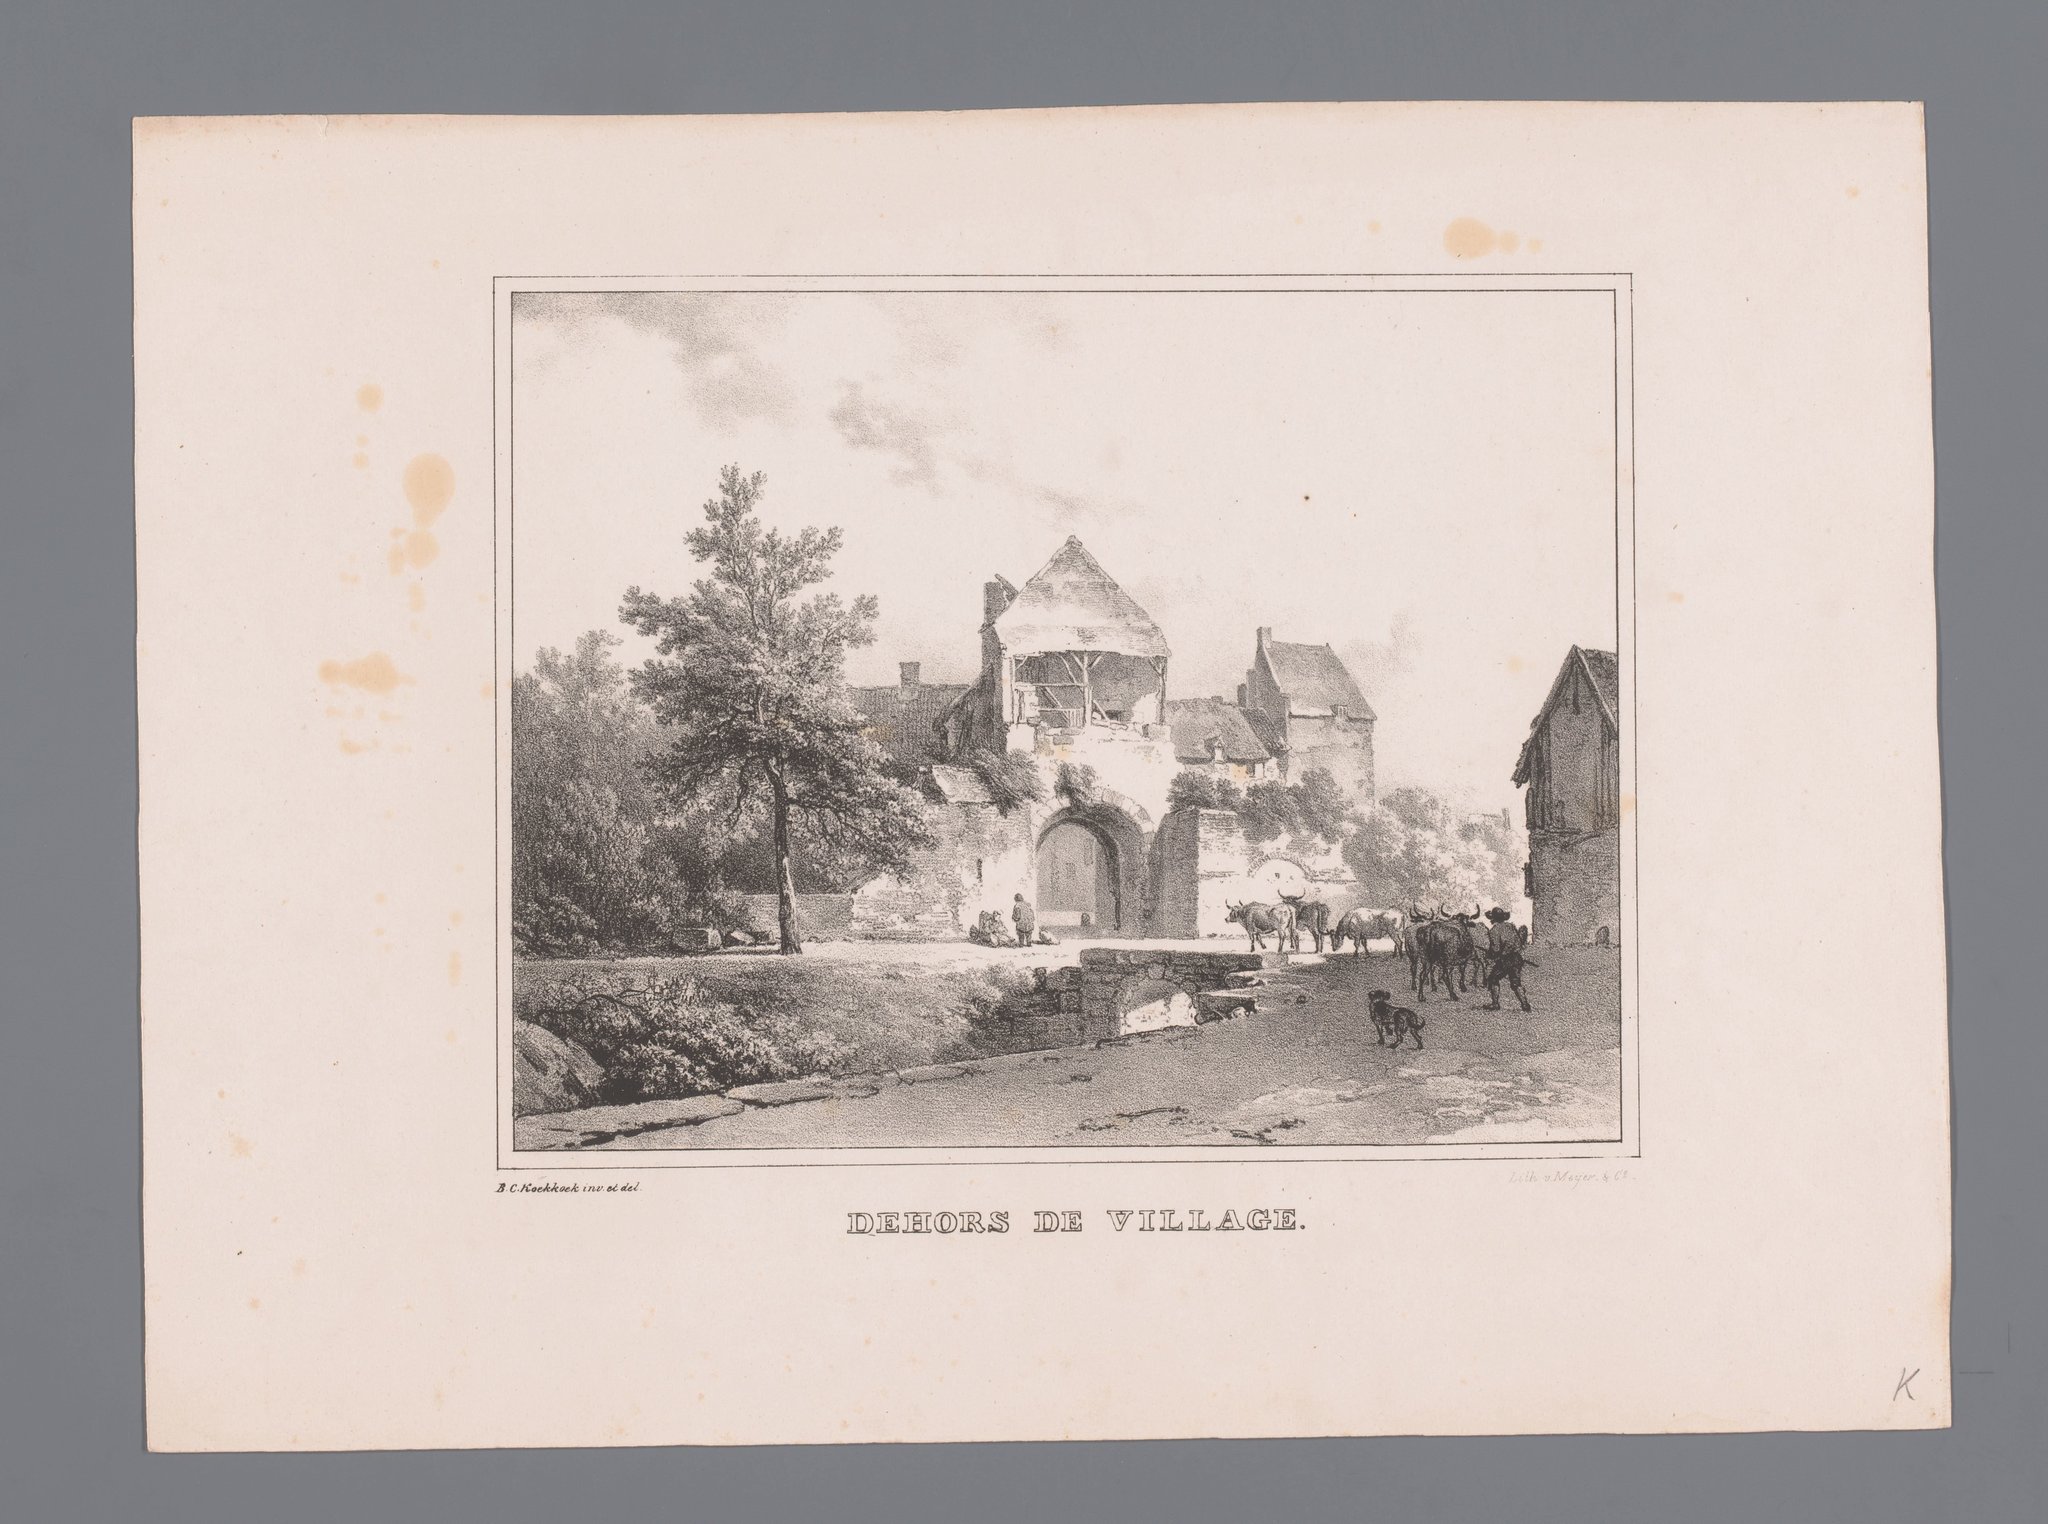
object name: print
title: Gezicht op een stadspoort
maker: barend cornelis koekkoek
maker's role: draughtsman, painter, print maker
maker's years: 1803-1862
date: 1843-1856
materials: paper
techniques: lithograph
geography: amsterdam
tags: herding, herdsman, herdswoman, shepherd, shepherdess, cowherd, etc., cattle driving, cattle driver, city-gate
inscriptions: collector's mark: Lugt 2228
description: Een herder met een kudde koeien loopt richting een stadspoort